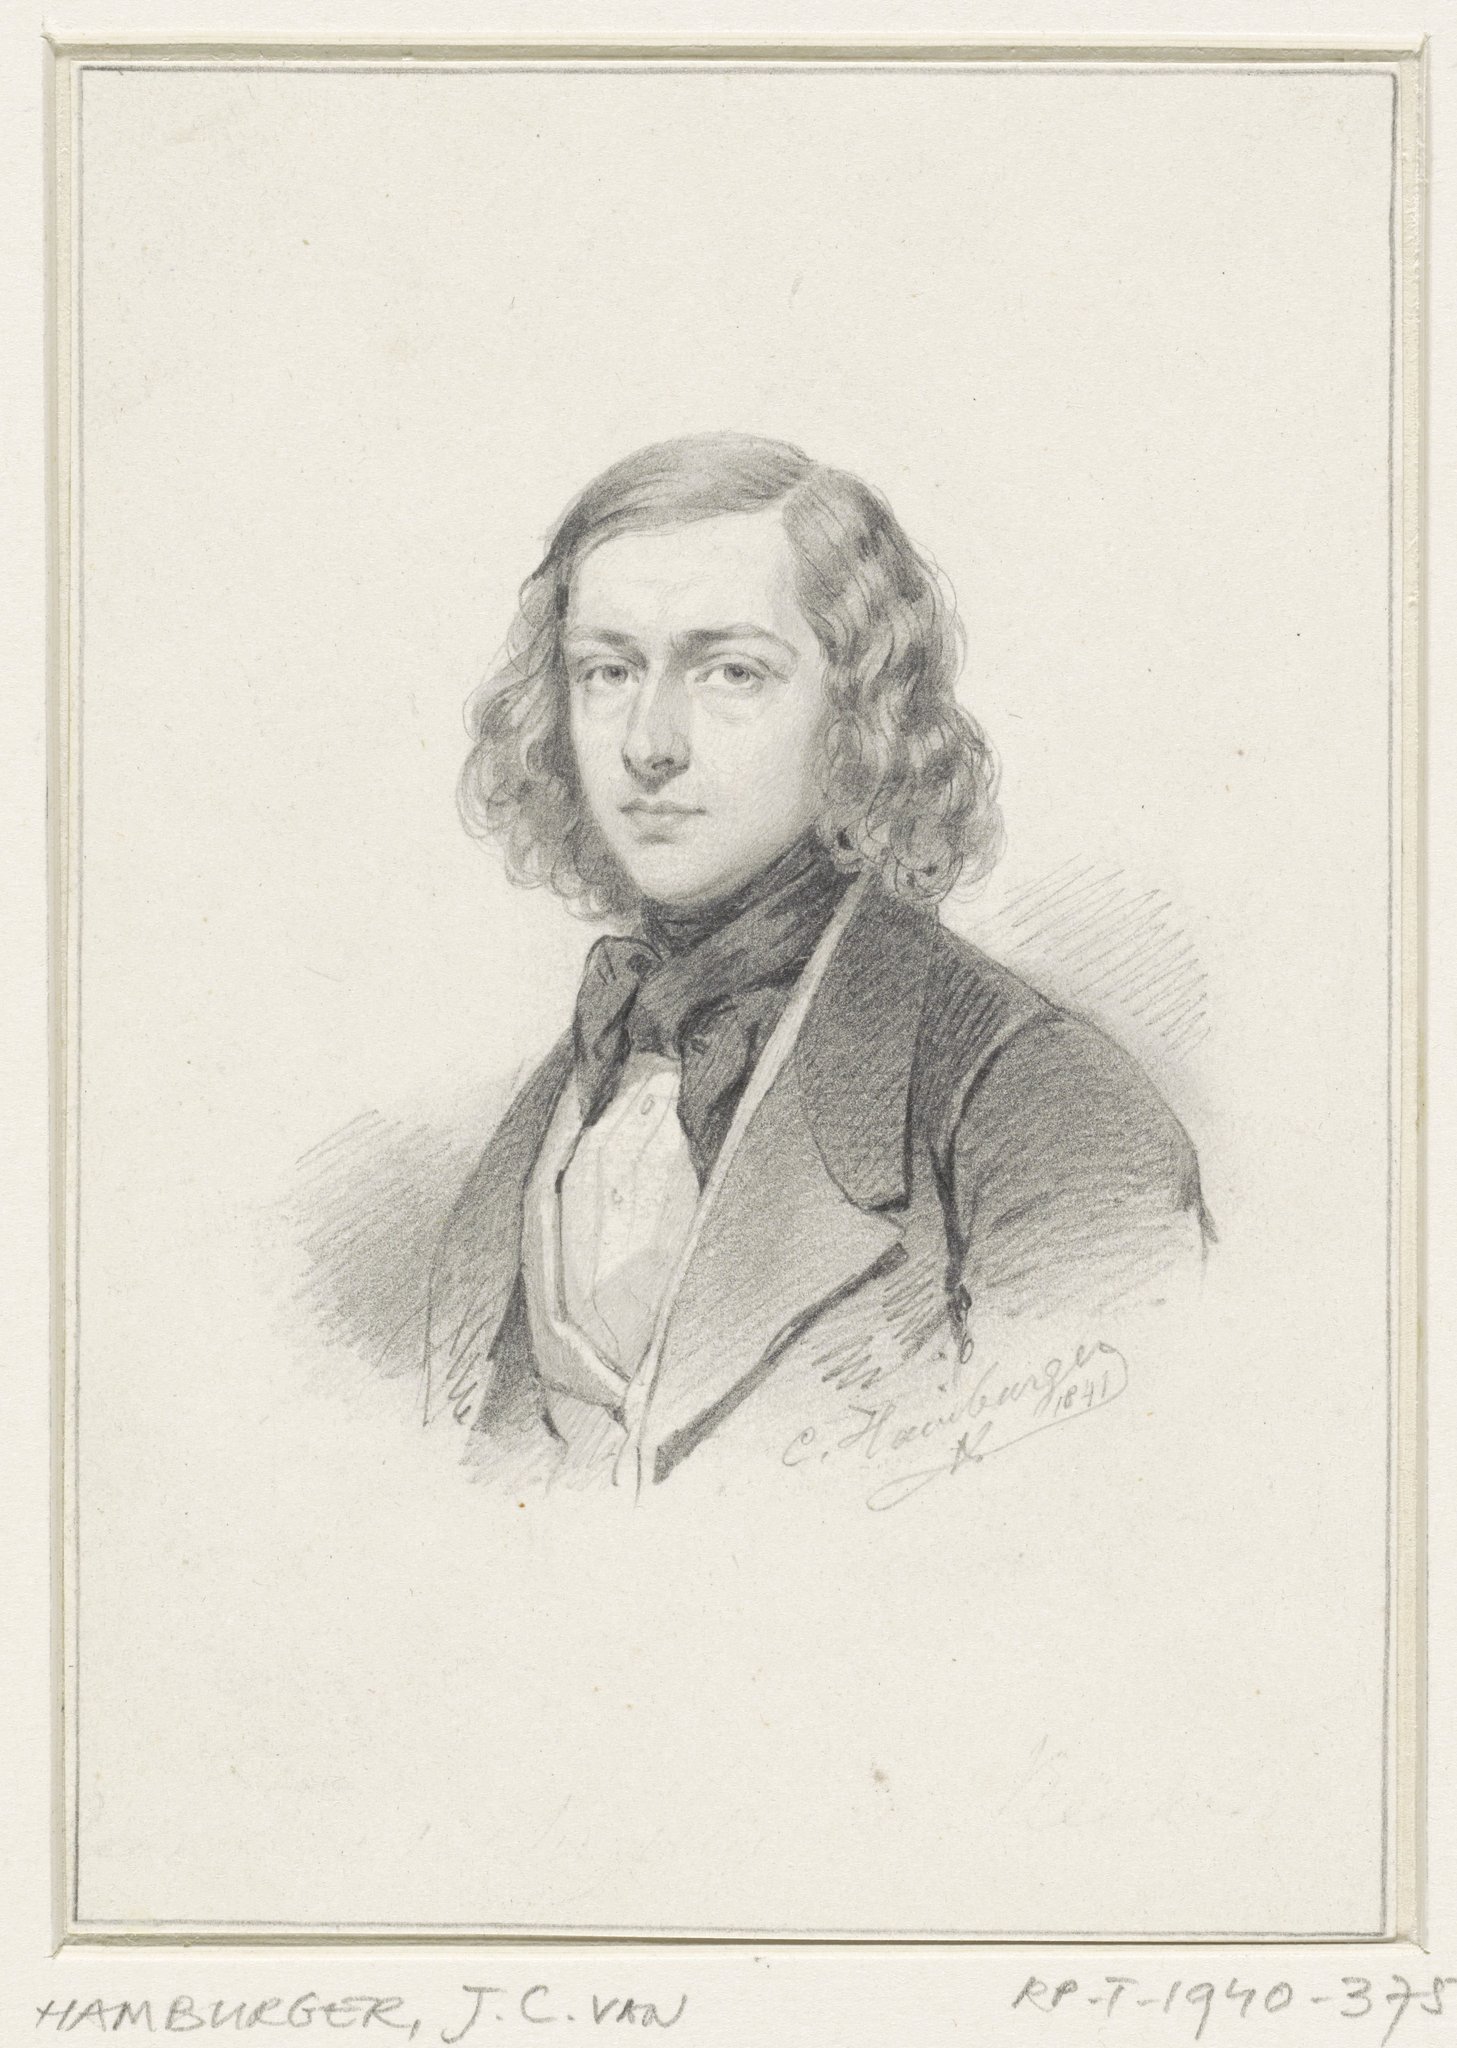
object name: drawing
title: Portret van Johannes Reekers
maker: coenraad hamburger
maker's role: draughtsman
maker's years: 1809-1891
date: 1841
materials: paper, pencil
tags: haarlem, johannes reekers (i), historical persons, portrait, self-portrait of artist